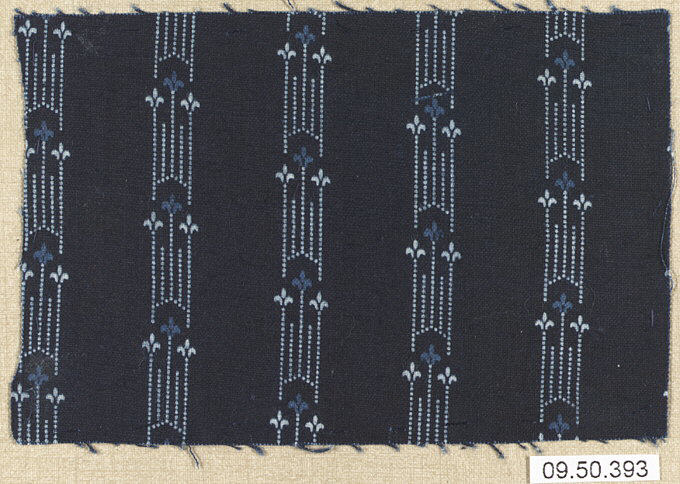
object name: piece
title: Piece (one of 116)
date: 1801-1900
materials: cotton